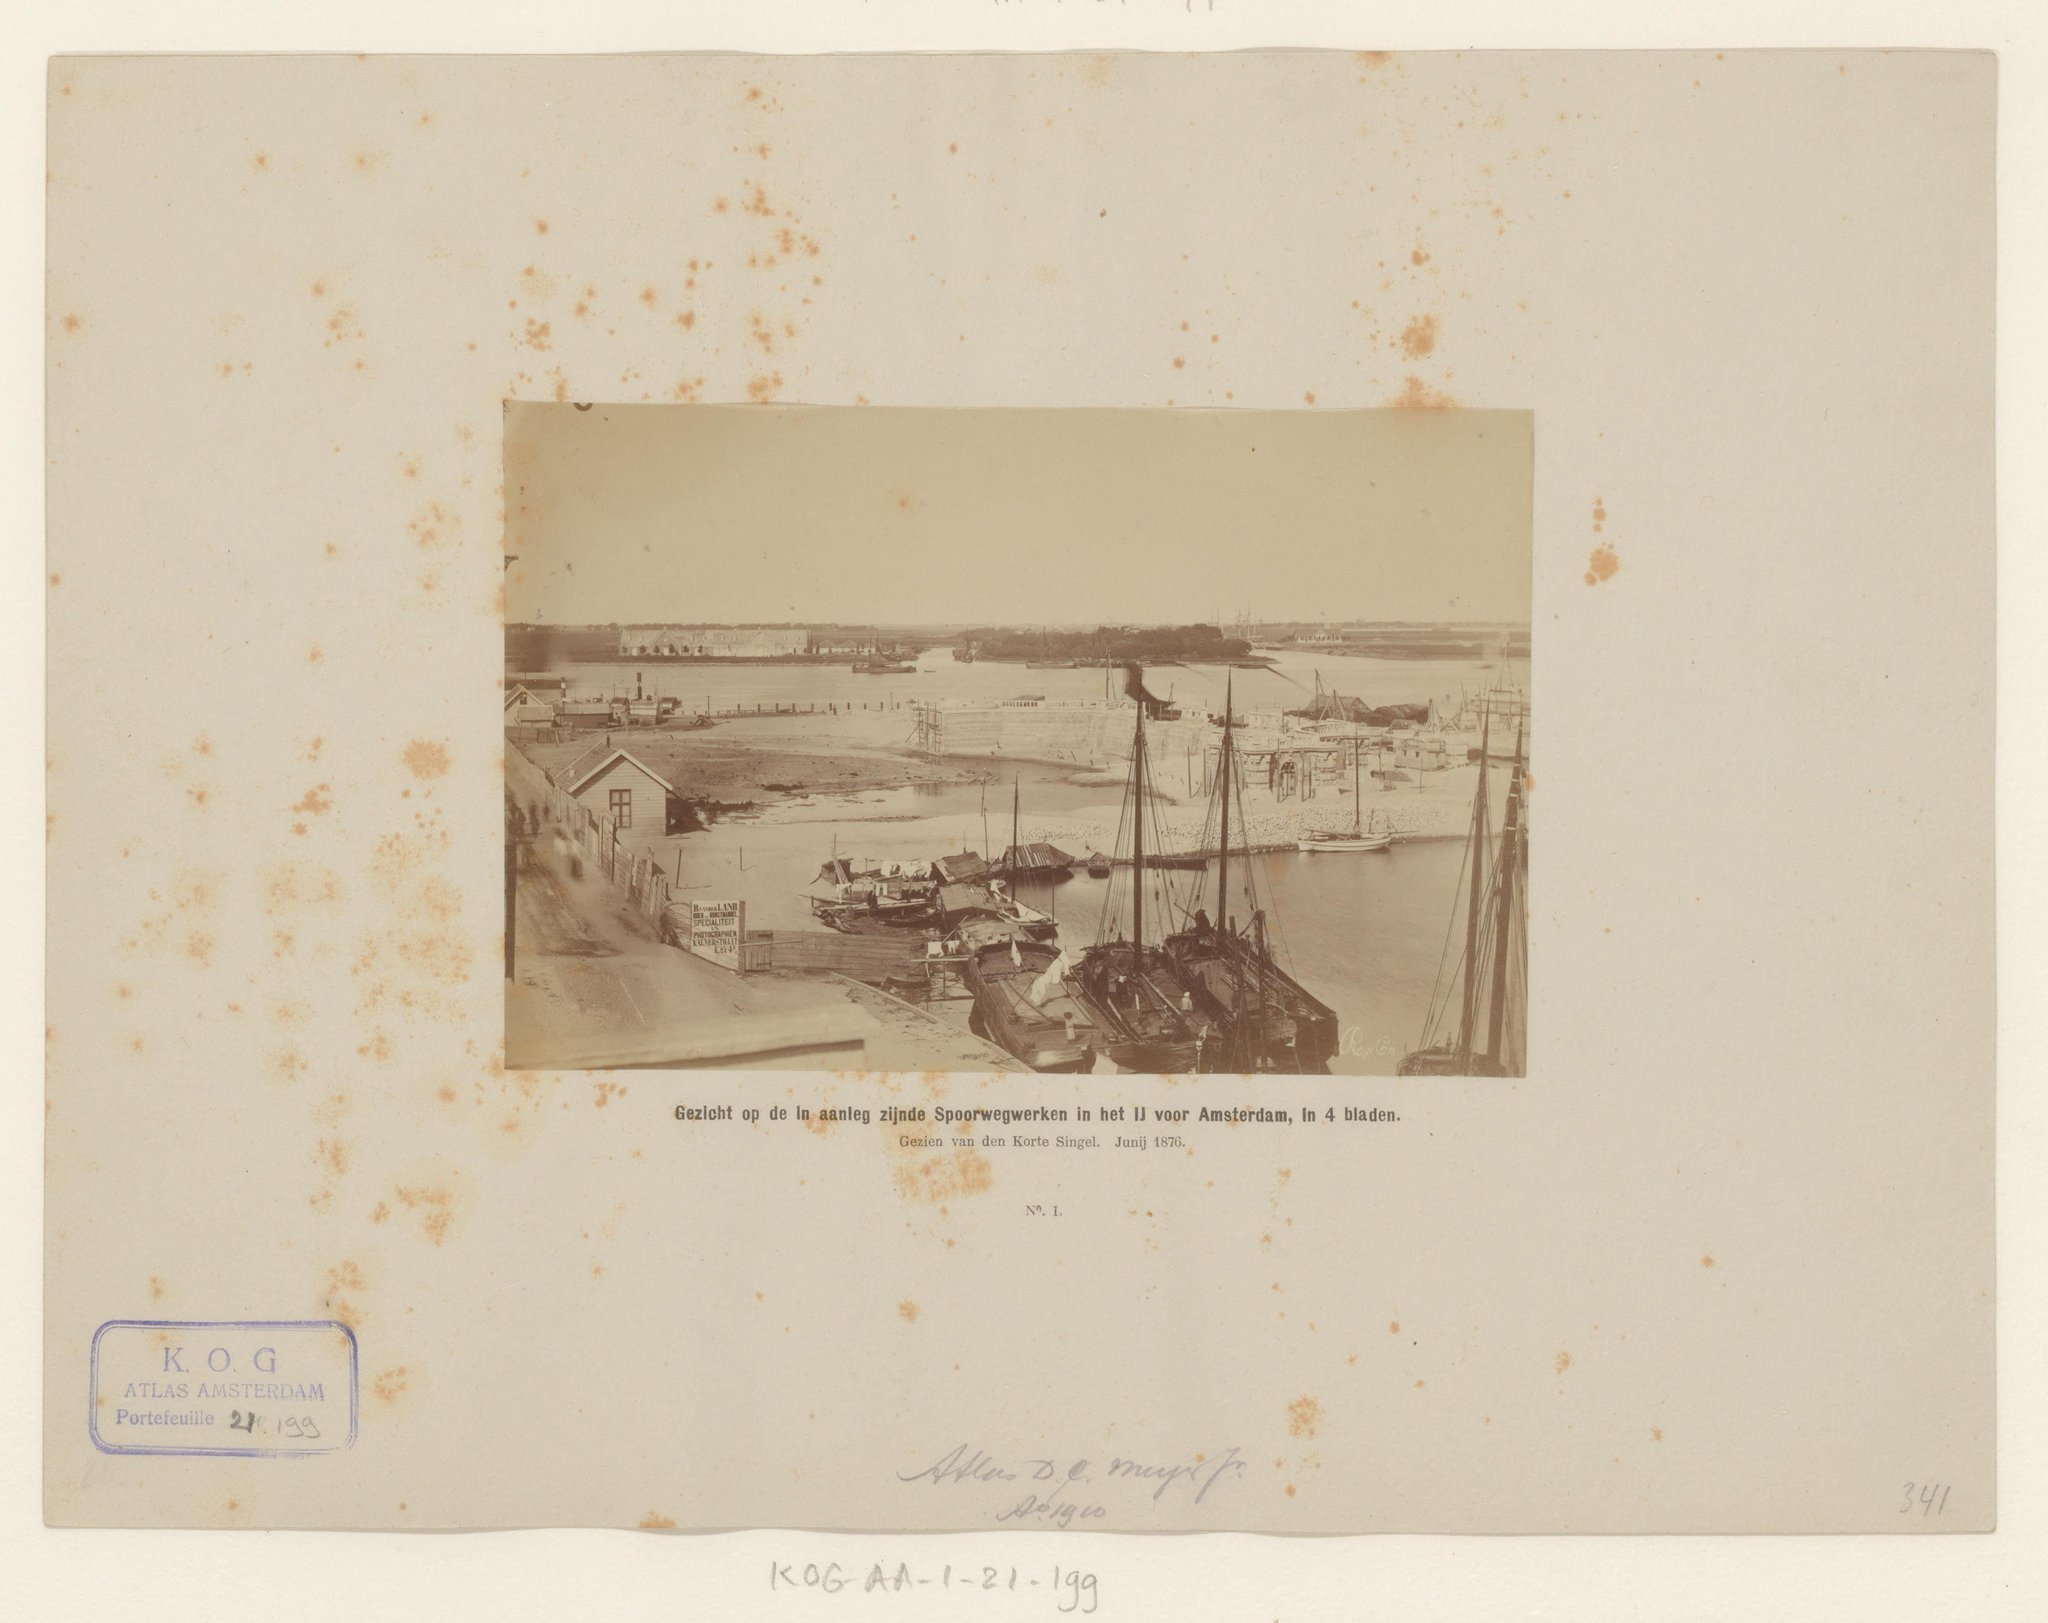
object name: photograph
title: Gezicht op het in aanleg zijnde Station Amsterdam Centraal, gezien vanaf de Korte Singel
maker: Anonymous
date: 1876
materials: cardboard, paper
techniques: albumen print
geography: amsterdam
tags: railway, train, station; shelter (railway, tramway), building-site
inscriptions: collector's mark: ‘21.199’ Lugt 1641b, inscription: ‘Atlas D.G. Meys Jr. / A°. 1910’, signature: ‘R & Co.’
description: Midden onder genummerd: no. I. Onderwerpsrubriek binnen de Atlas Amsterdam: Opgravingen.